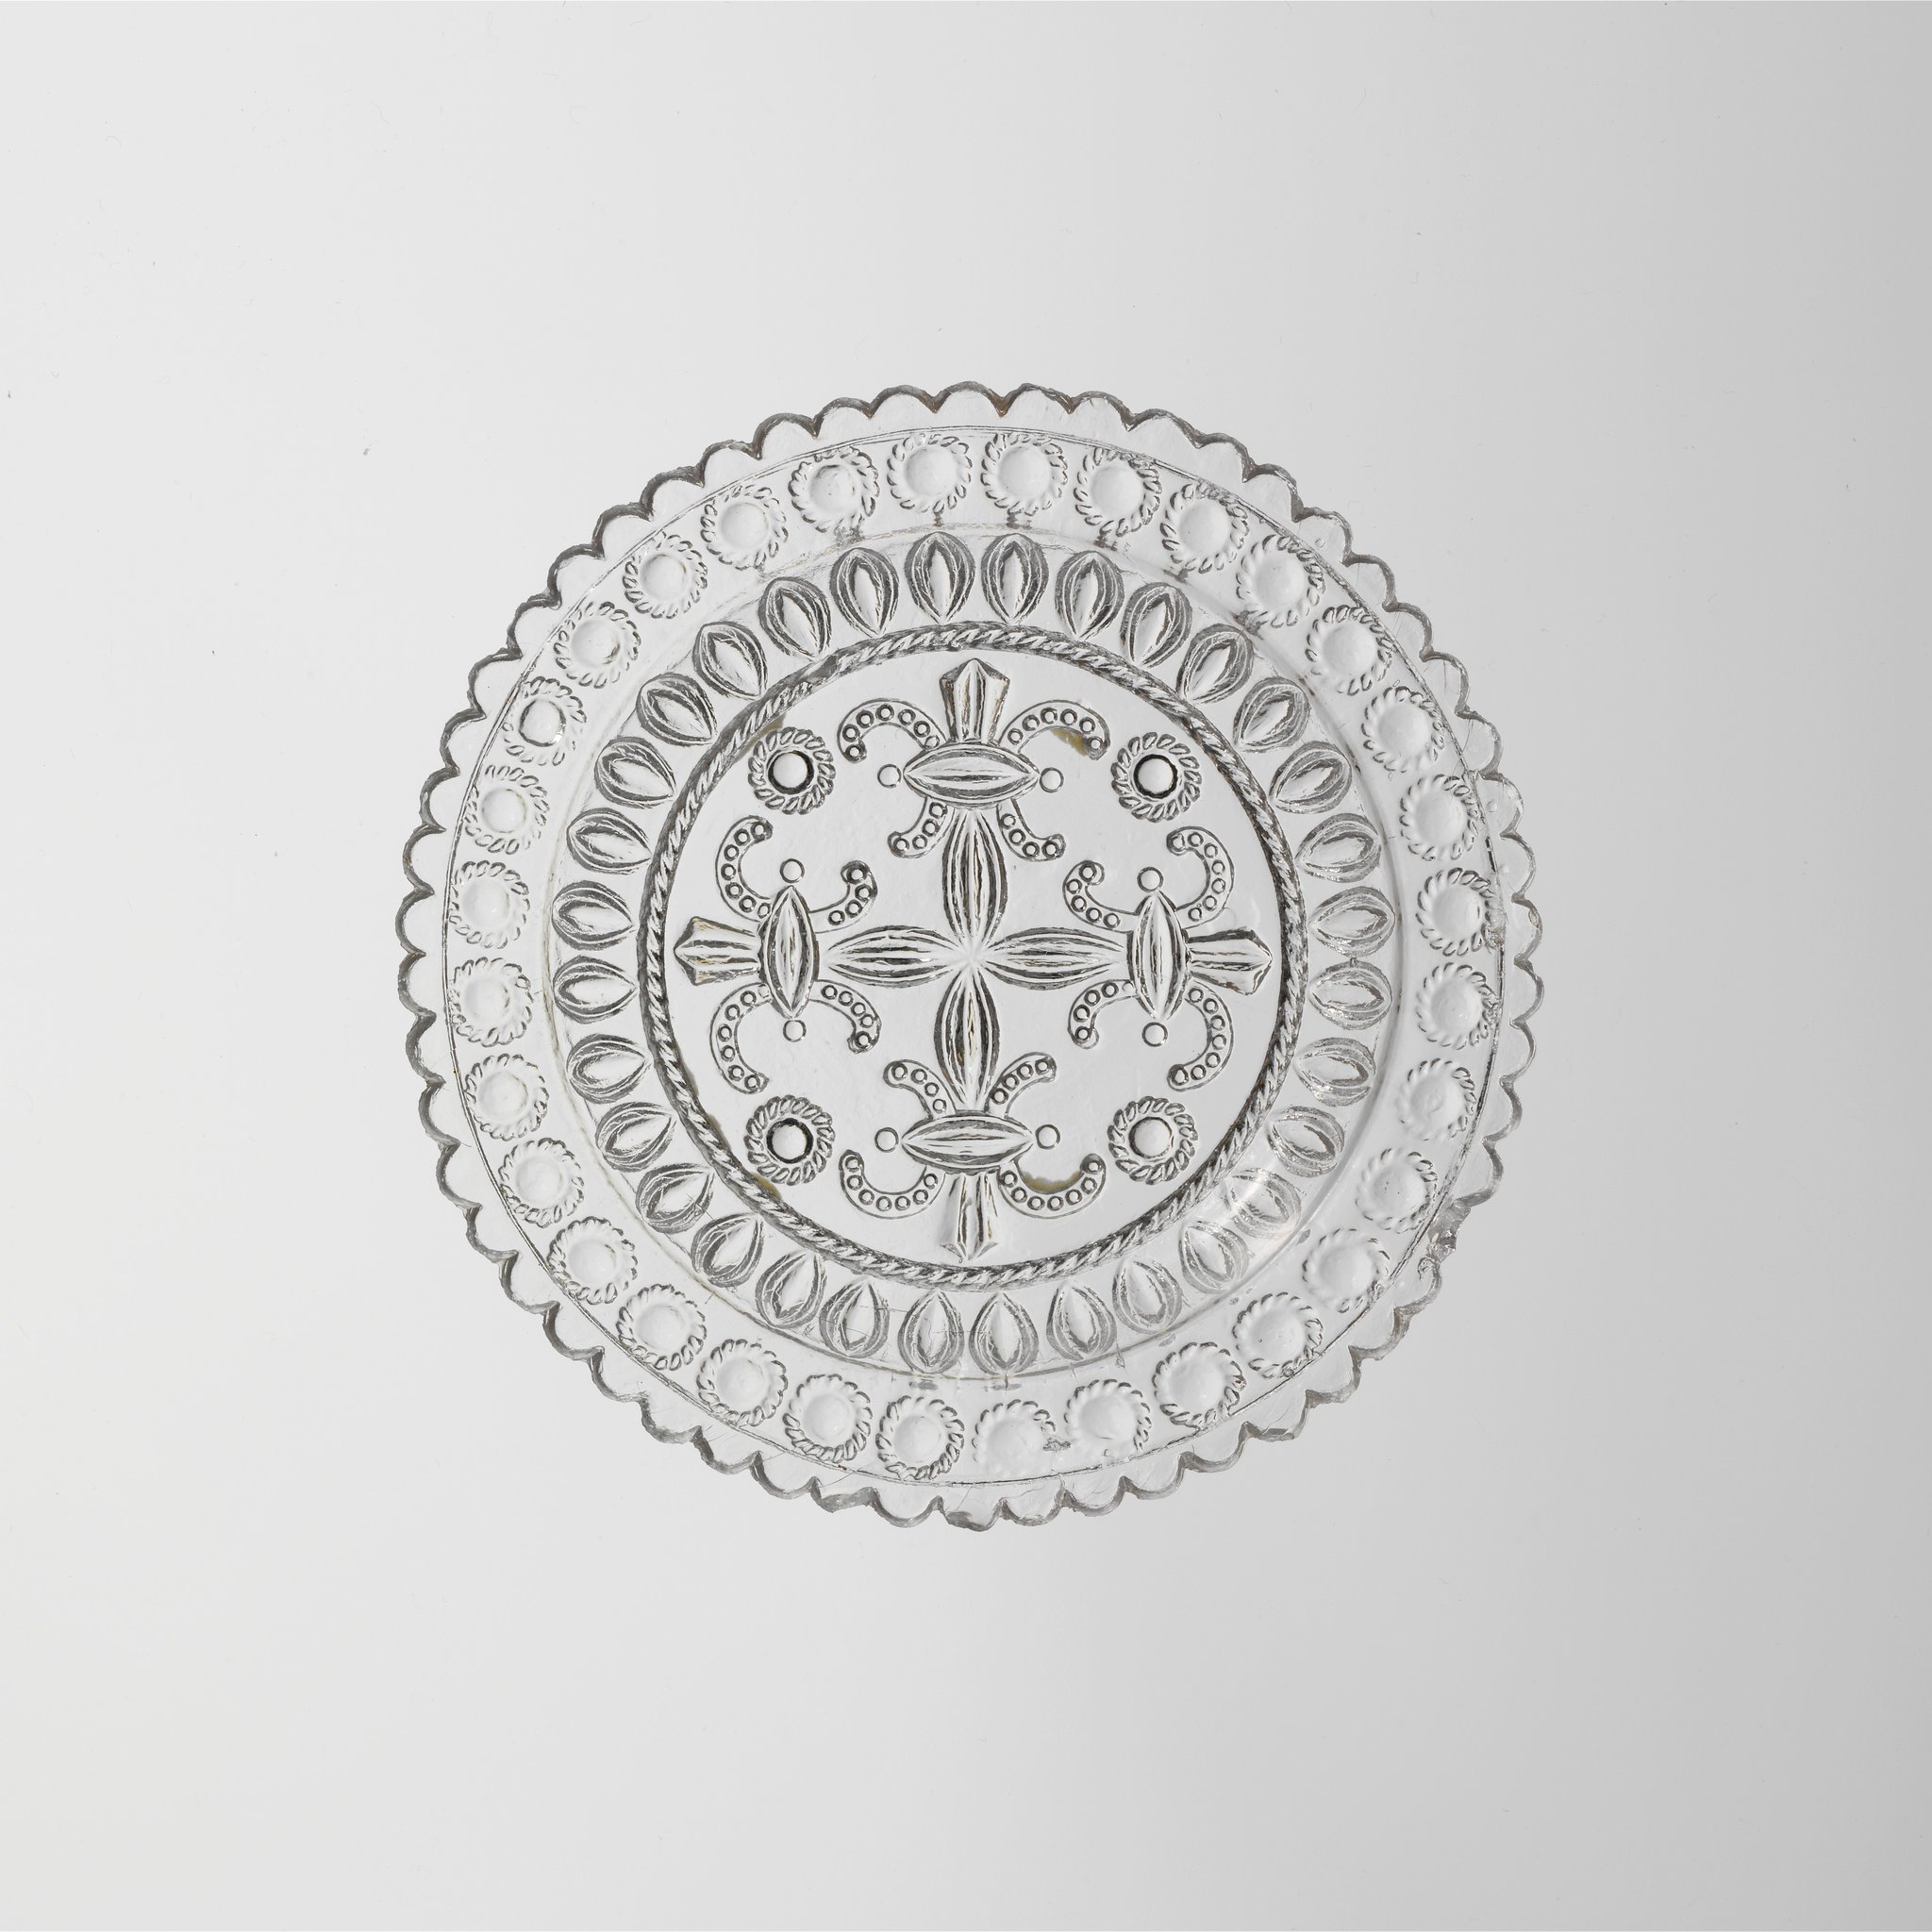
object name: cup plate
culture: american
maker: fort pitt glass works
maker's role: maker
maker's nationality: american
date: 1825-1860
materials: glass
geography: united states